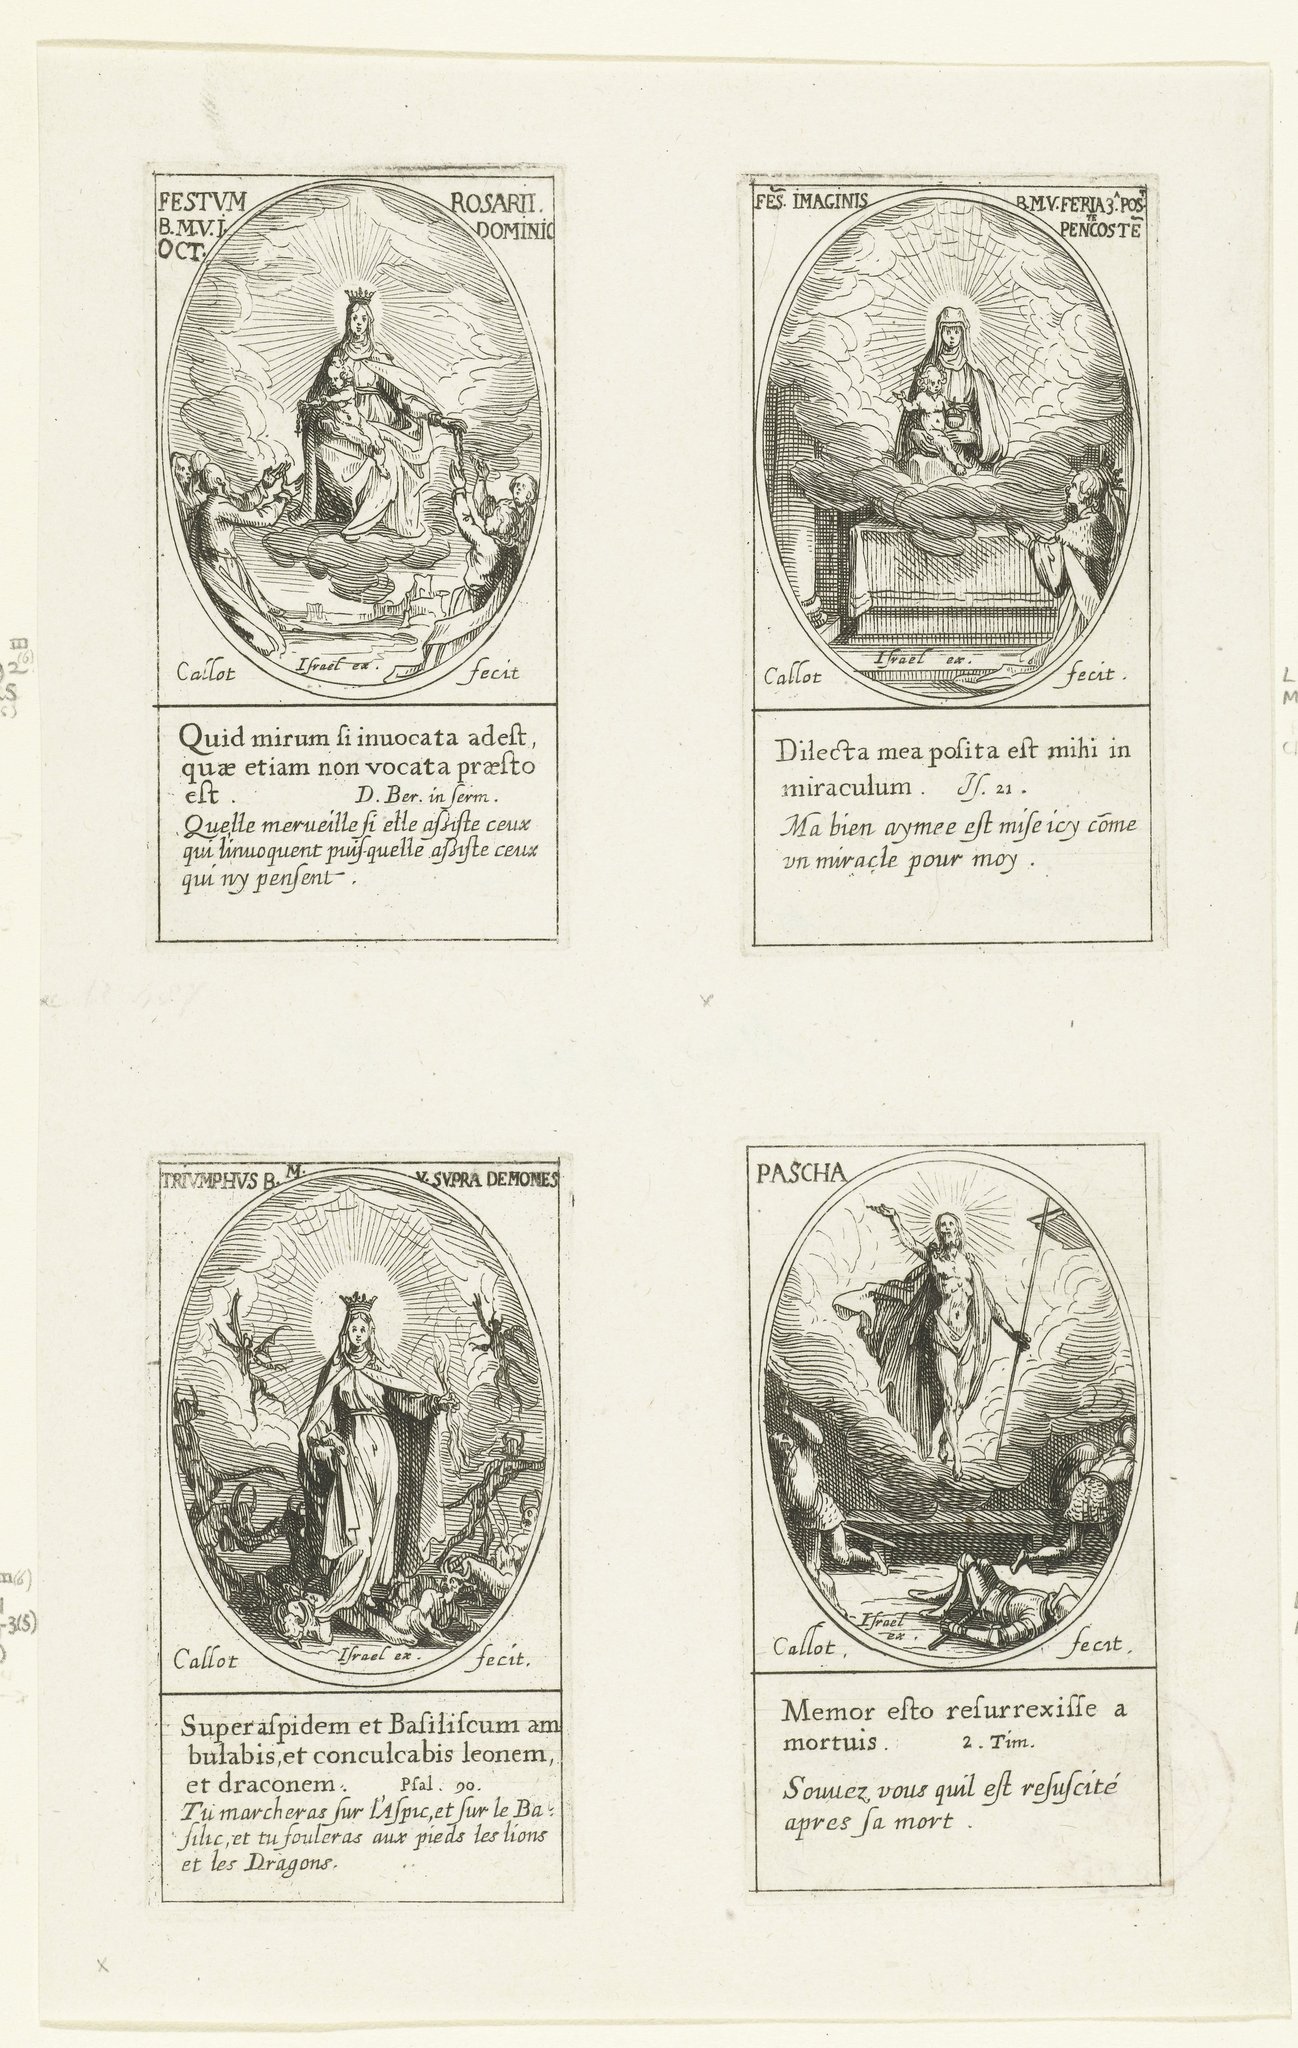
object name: print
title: Maria en het Christuskind delen rozenkransen uit (Rozenkransfeest), Maria en het Christuskind aanbeden door een koningin, Maria overwint het Kwaad, Opstanding (Pasen)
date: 1632-1636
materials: paper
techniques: etching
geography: nancy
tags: aids for prayer, e.g. rosary, madonna (i.e. mary with the christ-child) accompanied or surrounded by others, christ, usually holding a banner, arises from the grave; often combined with sleeping and/or frightened soldiers, mary conquering the devil, madonna of the rosary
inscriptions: collector's mark: Lugt 240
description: Blad met vier ovale voorstellingen, elk met opschrift in het Latijn en onderschrift in het Latijn en het Frans: linksboven Maria met het Christuskind op schoot die beiden rozenkransen uitdelen, rechtsboven Maria met het Christuskind op schoot in een wolk boven een altaar waarvoor een koningin knielt, linksonder Maria die duivelse wezens vertrapt en verjaagt, rechtsonder Christus die uit zijn graf verrijst. Deze prent is onderdeel van een serie prenten met voorstellingen van de heiligen en de christelijke feestdagen van het jaar. Er zijn steeds vier scènes van één plaat op één blad gedrukt. Inclusief bijbehorend titelblad en frontispice gaat het in totaal om 124 platen (490 voorstellingen). De drie platen met de laatste 12 scènes (de veranderlijke christelijke feestdagen) zijn in de derde staat versneden tot 12 kleine plaatjes, en met een apart titelblad uitgegeven.